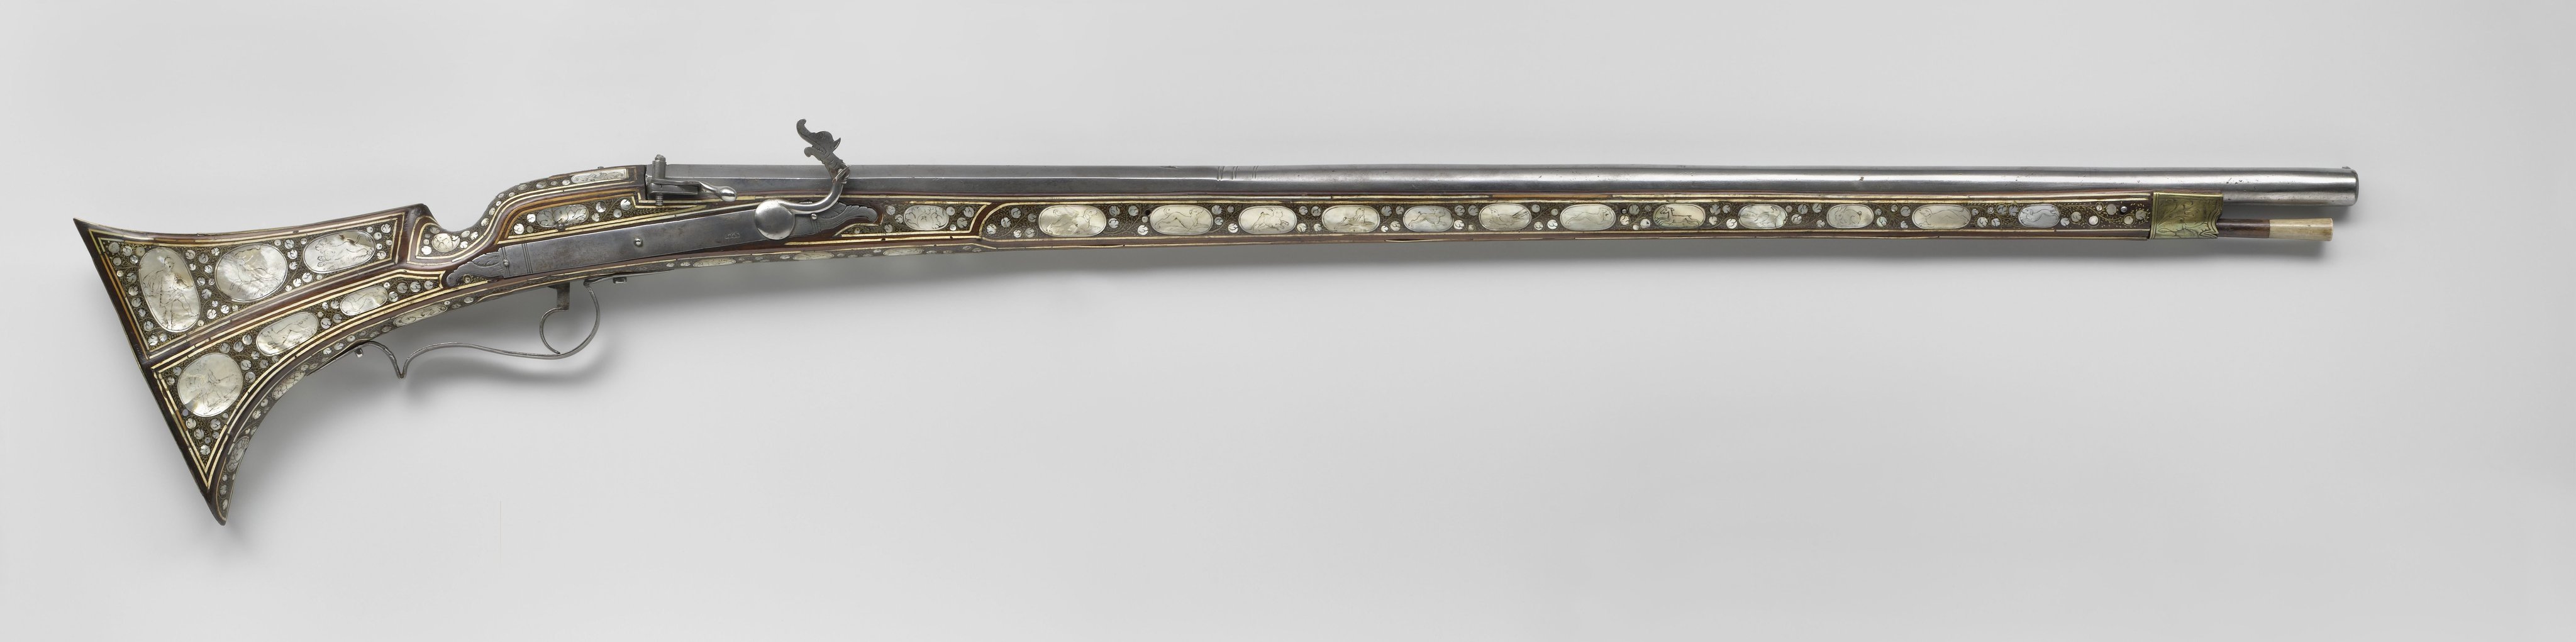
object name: lontslotwapen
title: Matchlock musket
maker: Anonymous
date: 1600-1650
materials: brass, horn, iron, mother of pearl, wood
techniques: printing, engraving, gilding, inlay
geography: netherlands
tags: hunting dogs, game, hunted animals, netherlands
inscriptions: mark: ‘HS; F’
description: Alongside the production of standard weapons, during the 17th century gunmakers began to specialize in luxury firearms. They worked for rich patrons and made a good living in the process. For this reason, it is curious that so few of these luxury weapons were signed by their makers. The stock of this musket is inlaid with mother-of-pearl plaques with scenes of hunters and animals.